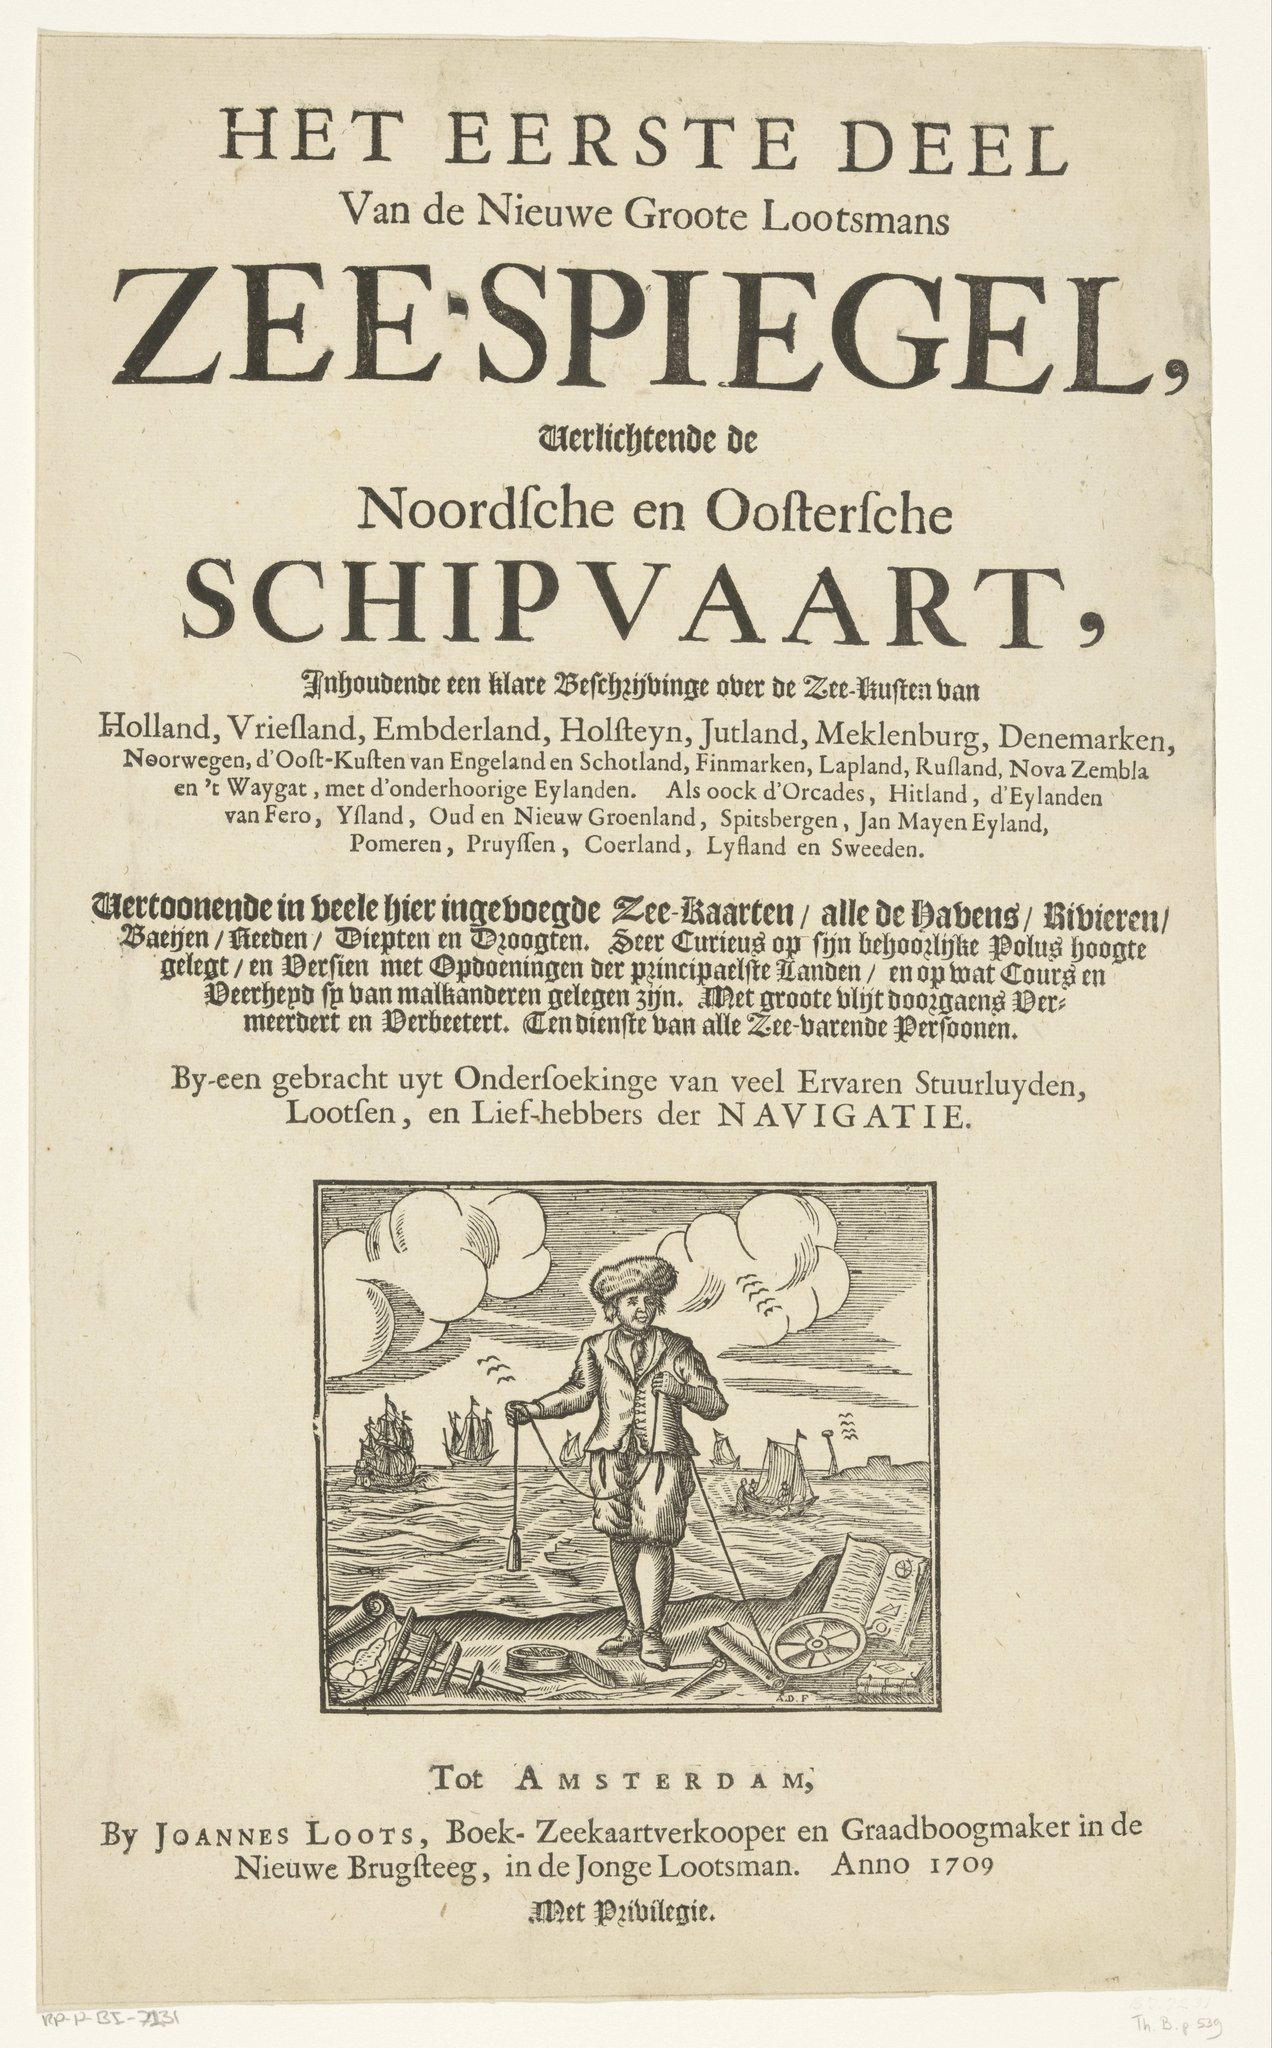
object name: print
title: Titelvignet voor: Het eerste deel van de nieuwe groote Lootsmans zee-spiegel, verlichtende de noordsche en oostersche schipvaart, 1709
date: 1709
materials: paper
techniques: letterpress printing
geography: amsterdam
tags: astronomical instruments, ships (in general), sea (seascape), book, vignette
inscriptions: collector's mark: Lugt 2228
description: Titelvignet voor: Het eerste deel van de nieuwe groote Lootsmans zee-spiegel, verlichtende de noordsche en oostersche schipvaart. Amsterdam: Johannes Loots, 1709.